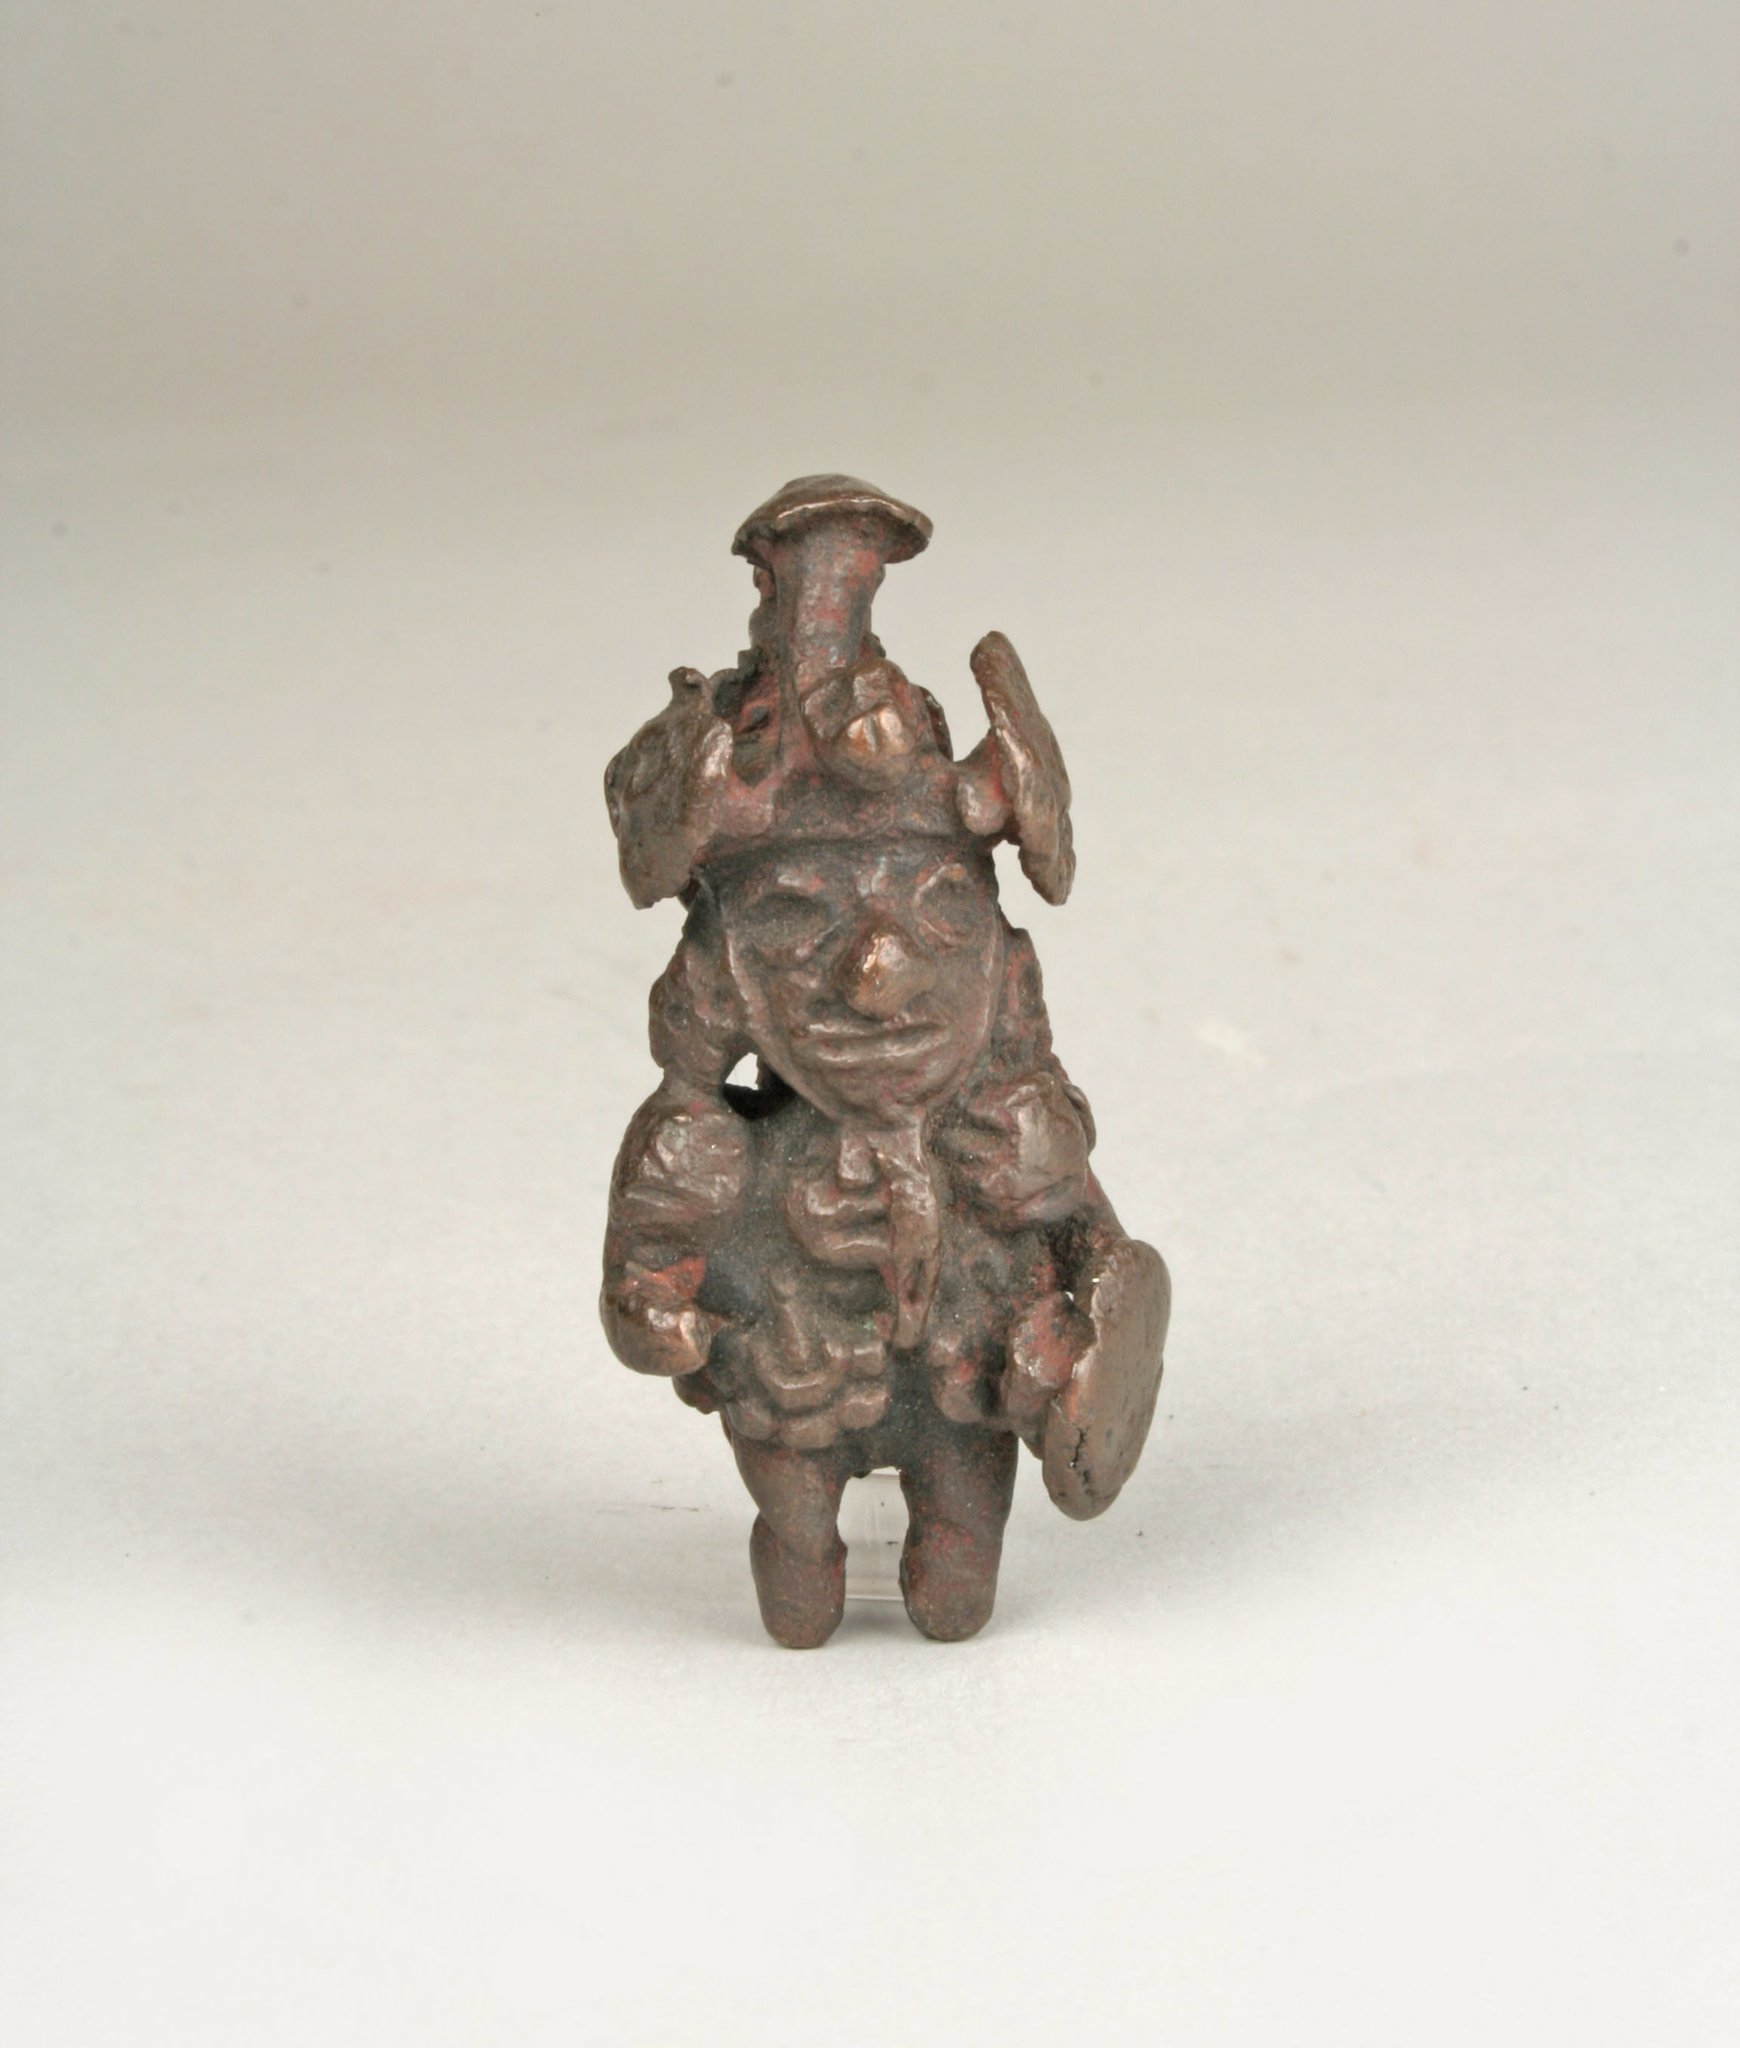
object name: warrior figure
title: Figure of a Warrior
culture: moche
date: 100 BCE-700 CE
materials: copper, pigment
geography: peru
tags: warriors